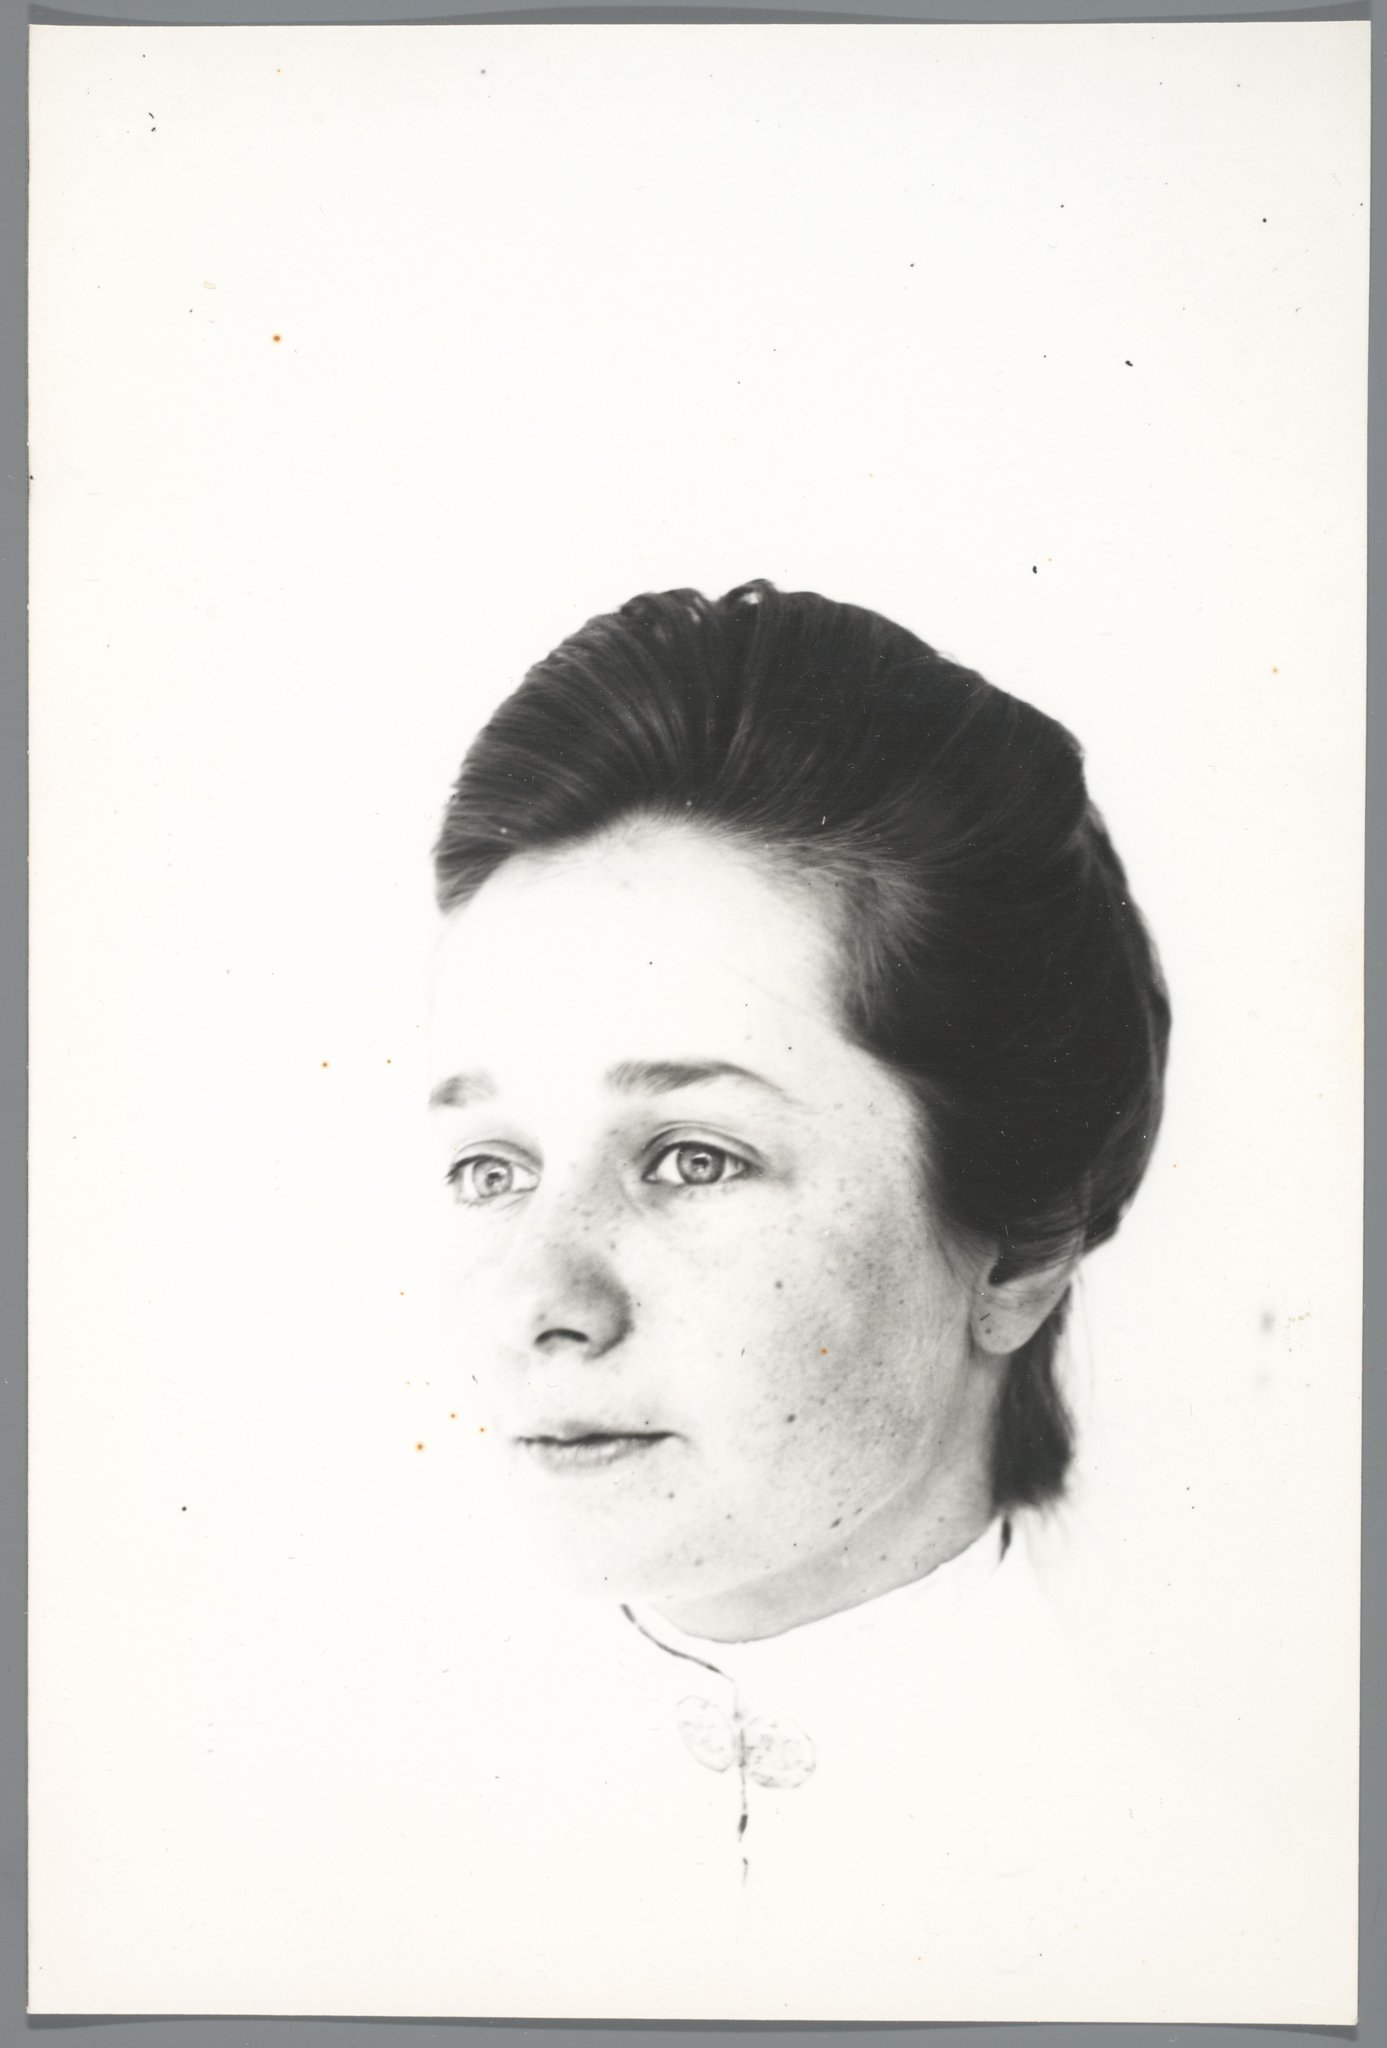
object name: photograph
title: Portret van een onbekende vrouw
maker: cornelia hendrika jonker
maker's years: 1874-1924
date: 1910-1960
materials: photographic support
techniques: gelatin silver print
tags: historical persons